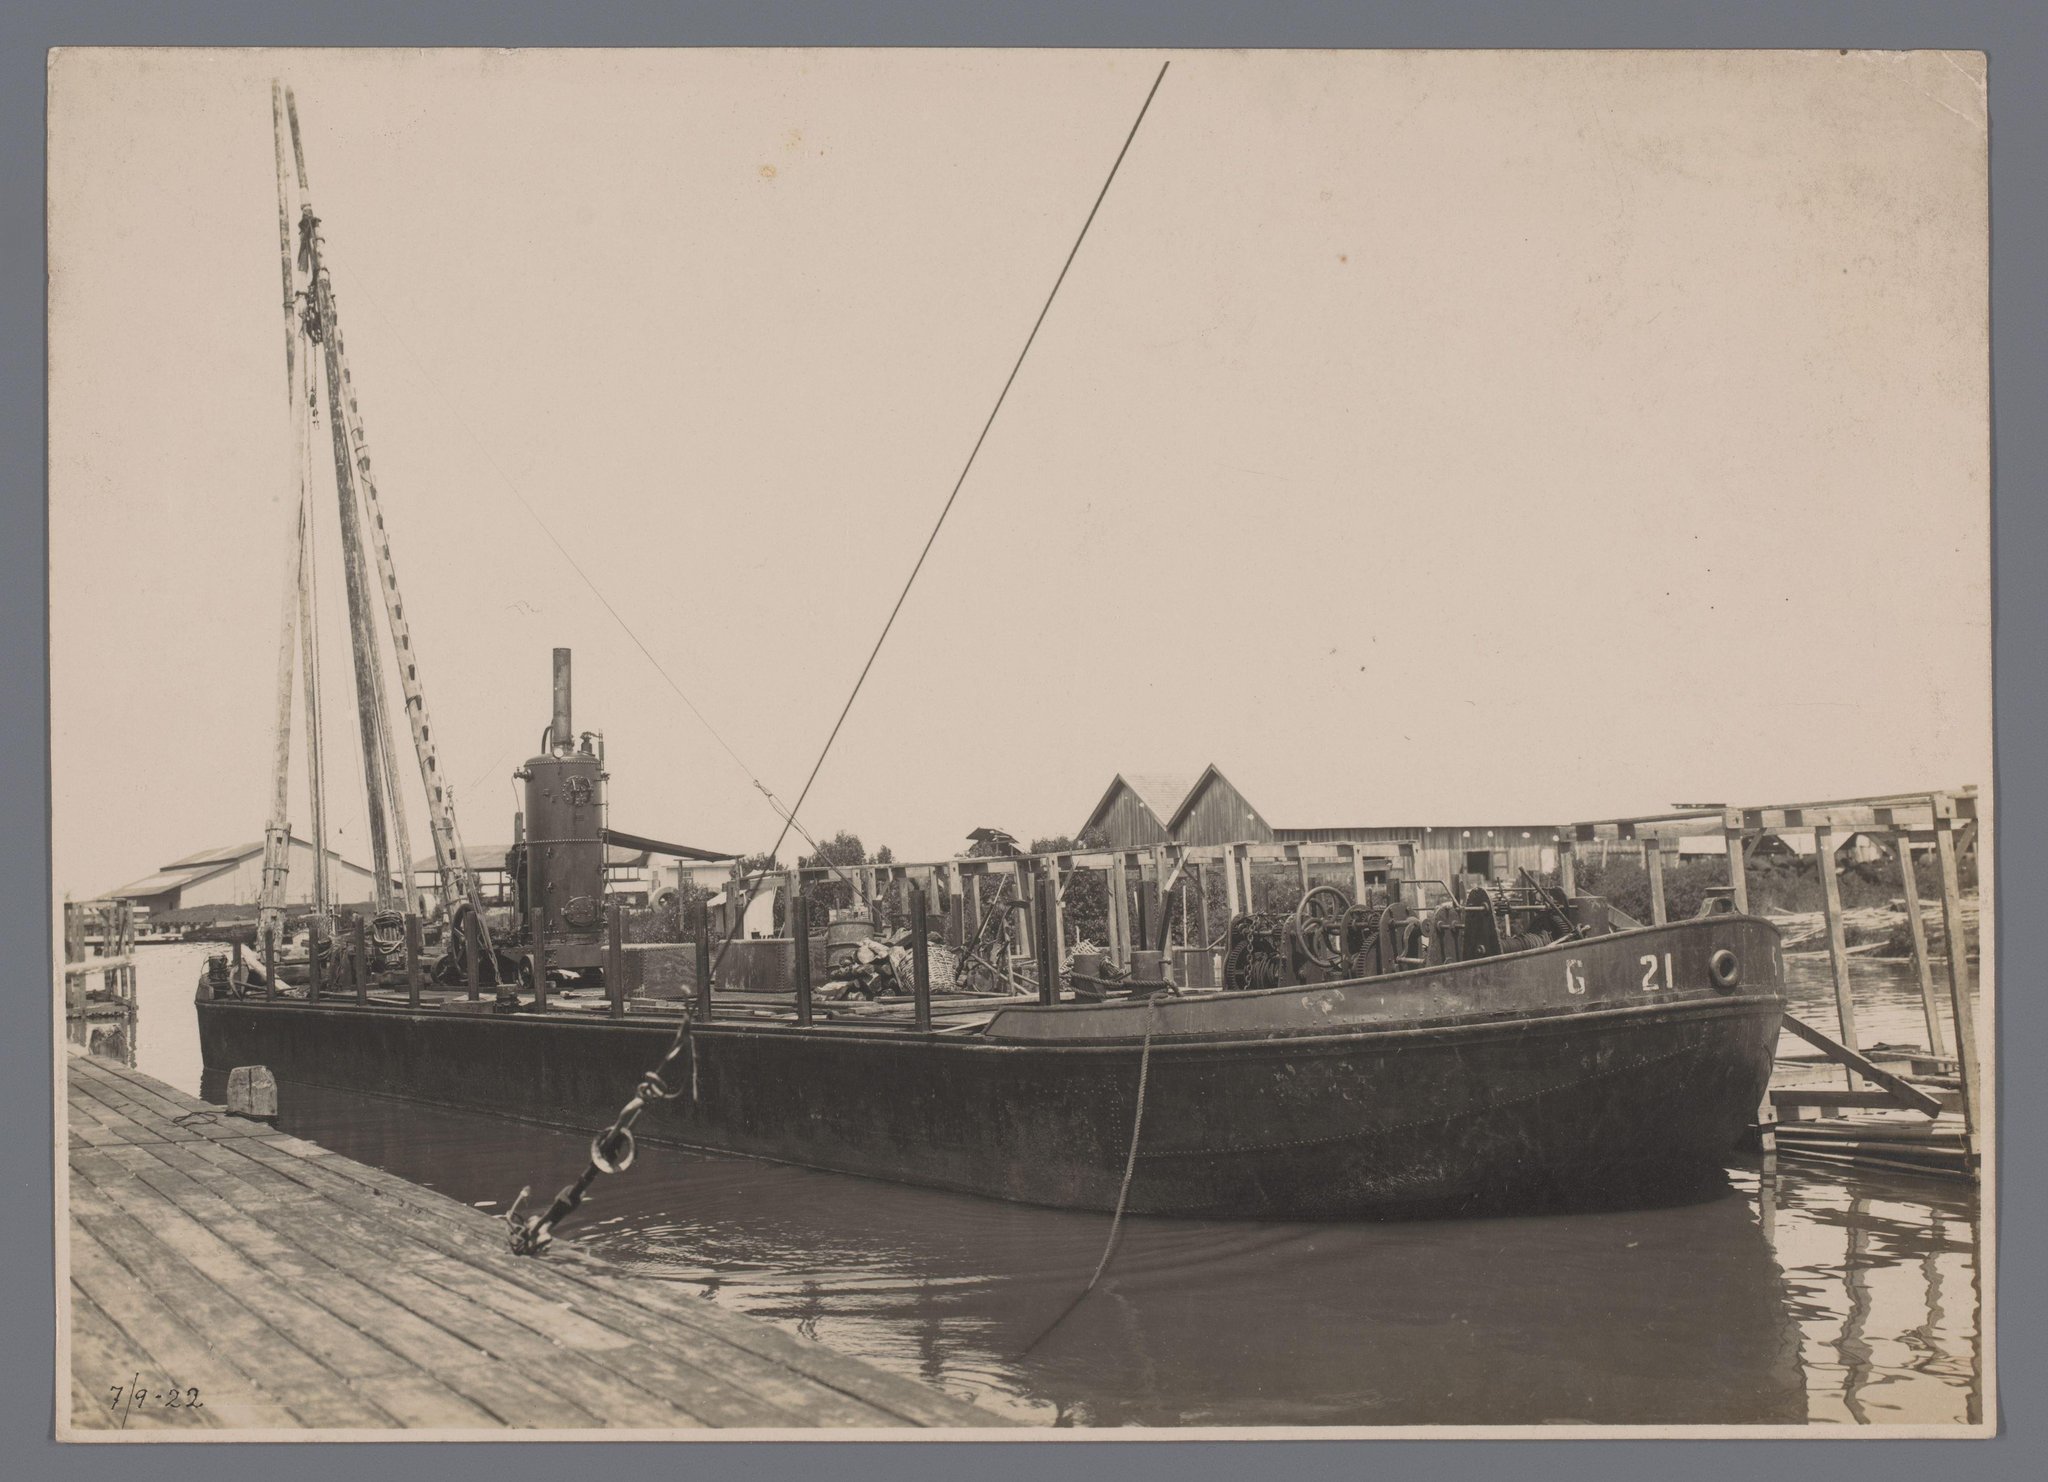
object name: photograph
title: Oceaanhaven Belawan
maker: Anonymous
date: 1922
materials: photographic support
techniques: gelatin silver print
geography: belawan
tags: harbour, ramming, driving piles (~ building activities), building-site, steamship, motorship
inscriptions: date: ‘7/9-22’, inscription: ‘No. 196 / Heibak G 21’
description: Schip met heimachine. Genummerd: 196. Onderdeel van de groep van losse foto's over de aanleg van de haven Belawan aan de kust voor Medan, Sumatra 1921-1922.